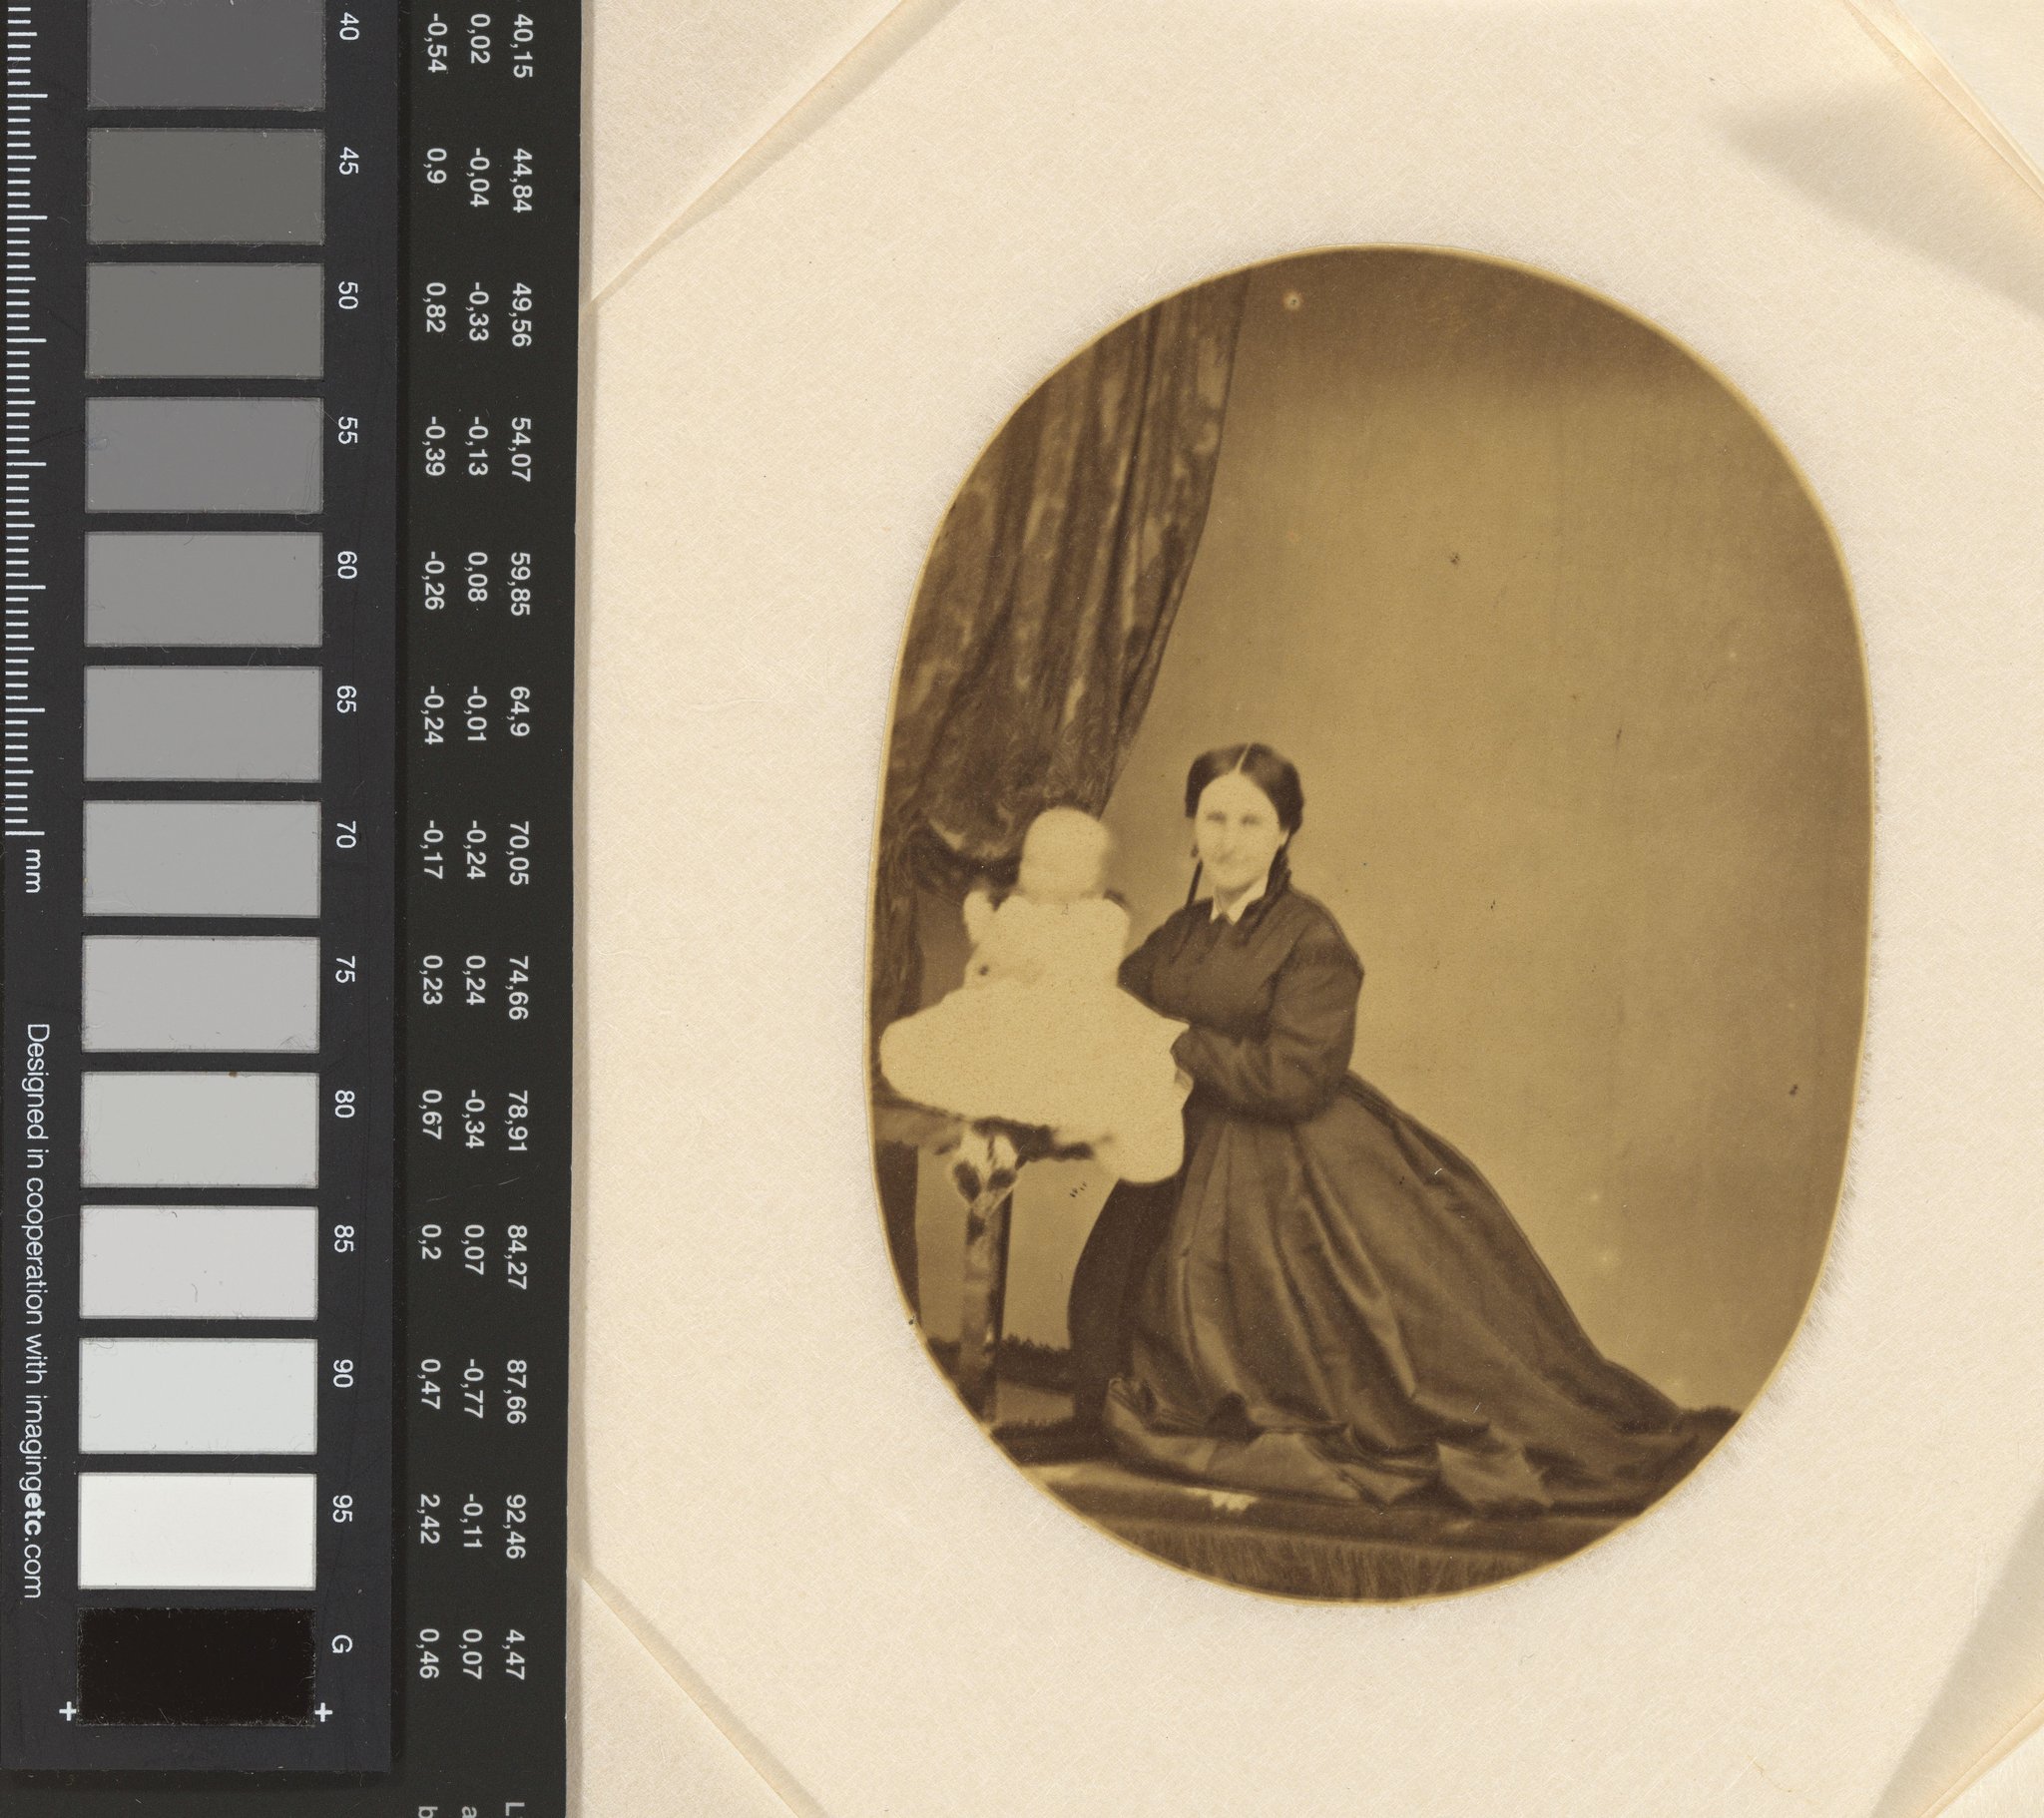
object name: photograph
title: Portret van een zittende vrouw met kind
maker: Anonymous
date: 1865-1875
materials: paper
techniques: albumen print